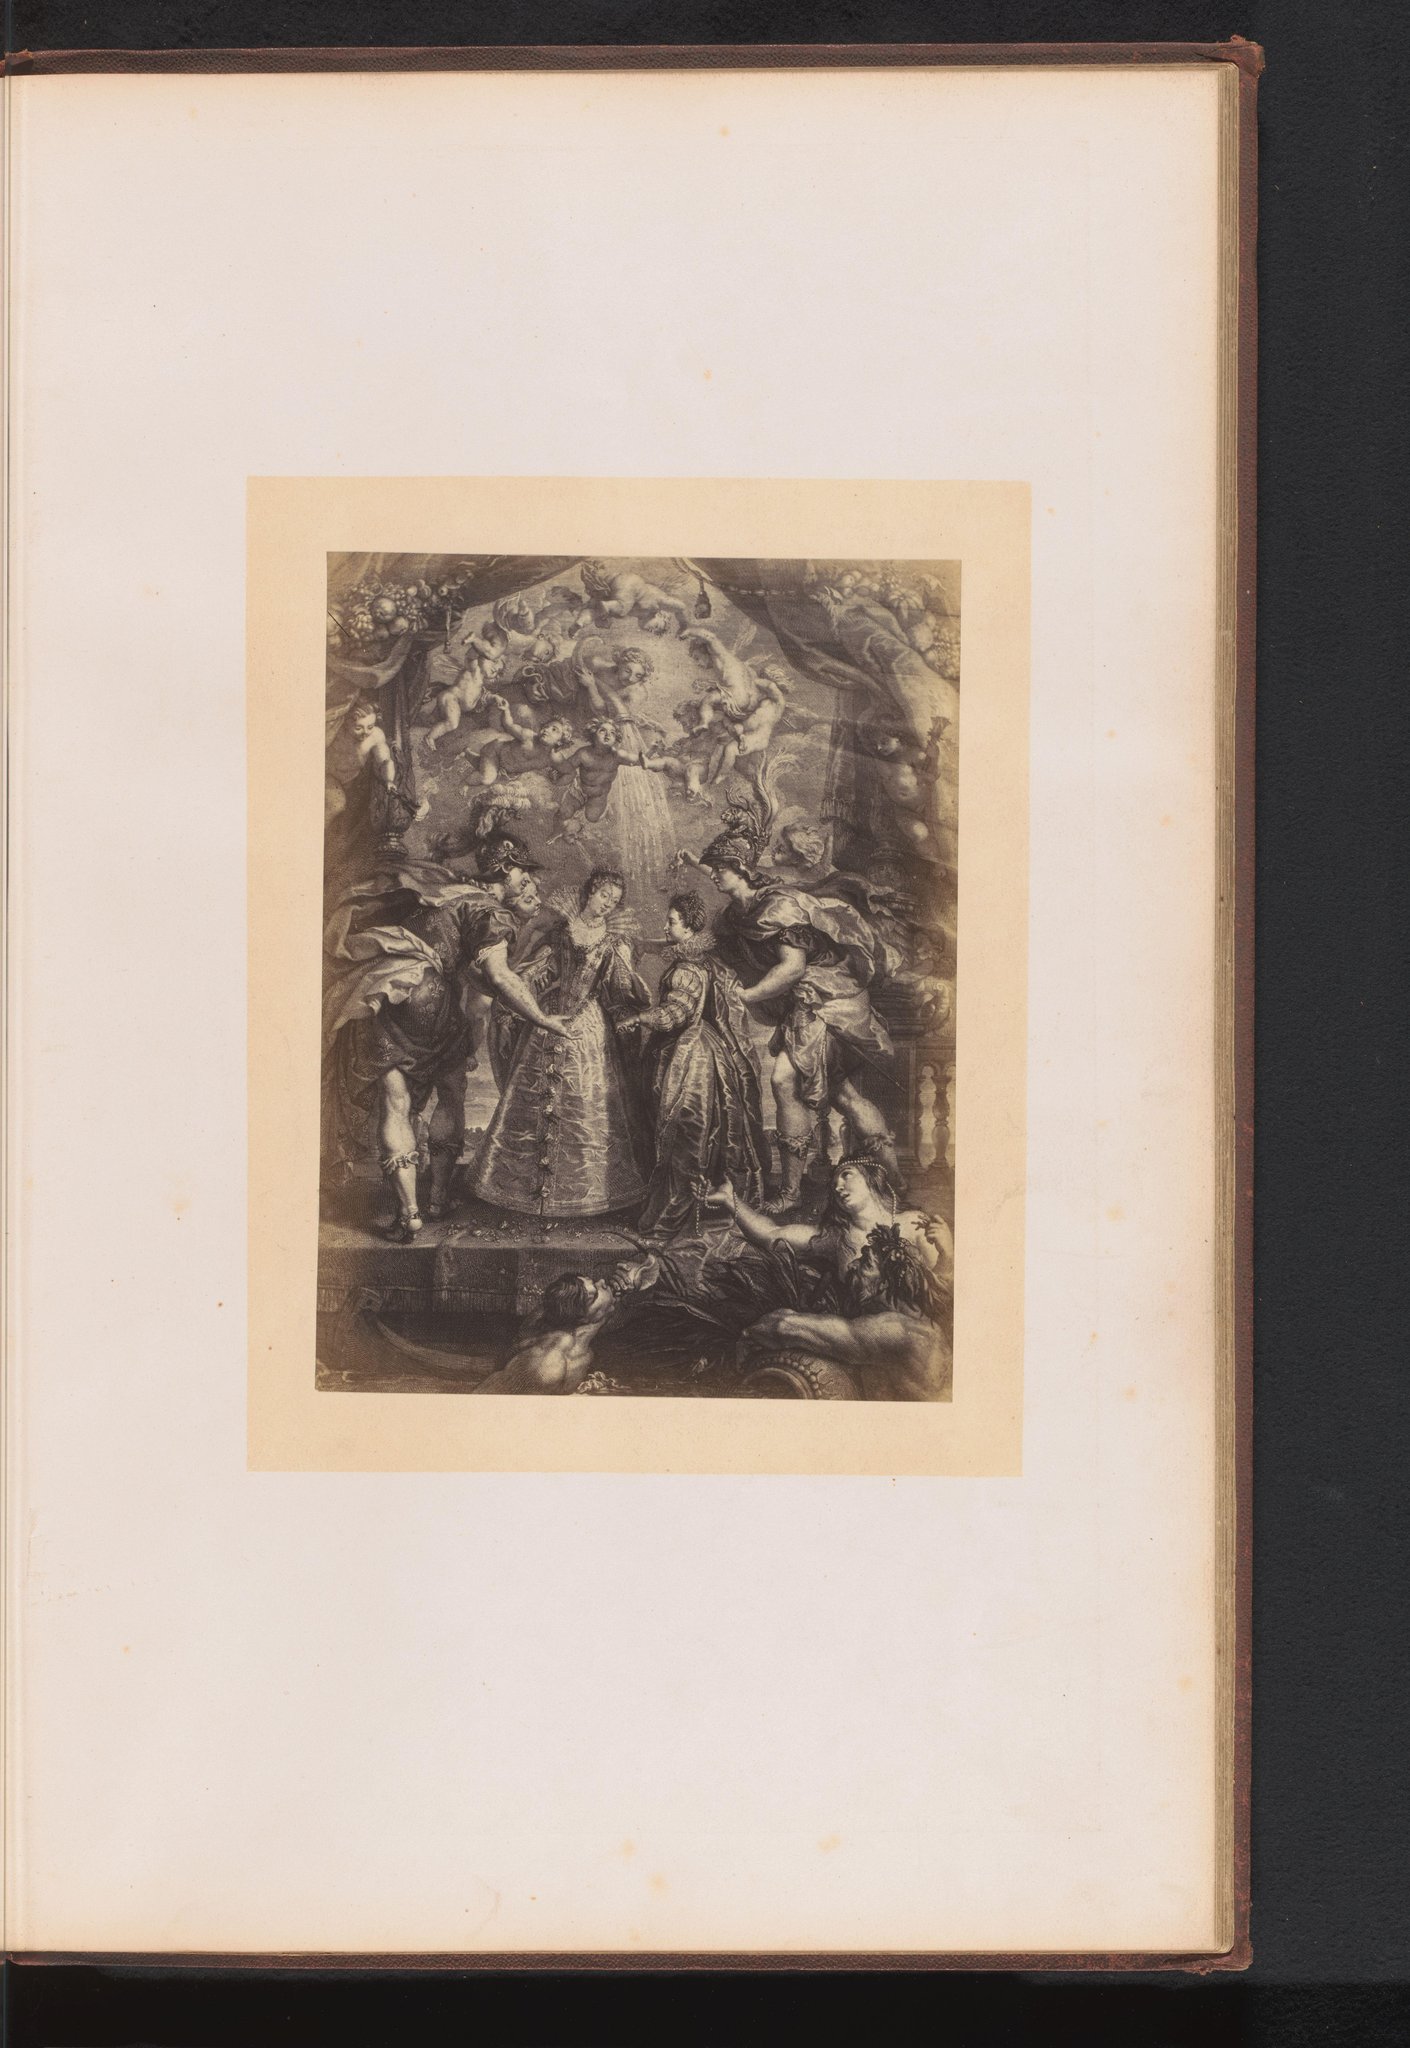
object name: photograph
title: Fotoreproductie van een gravure van De ontmoeting der prinsessen door Jean-Marc Nattier, naar het schilderij door Peter Paul Rubens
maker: peter paul rubens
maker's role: draughtsman, painter, print maker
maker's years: 1577-1640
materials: photographic support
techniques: albumen print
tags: elisabeth of france (queen of spain and portugal), filips iv (koning van spanje), paris, anna van oostenrijk (koningin van frankrijk), lodewijk xiii (koning van frankrijk), introducing, family of a ruler, and court